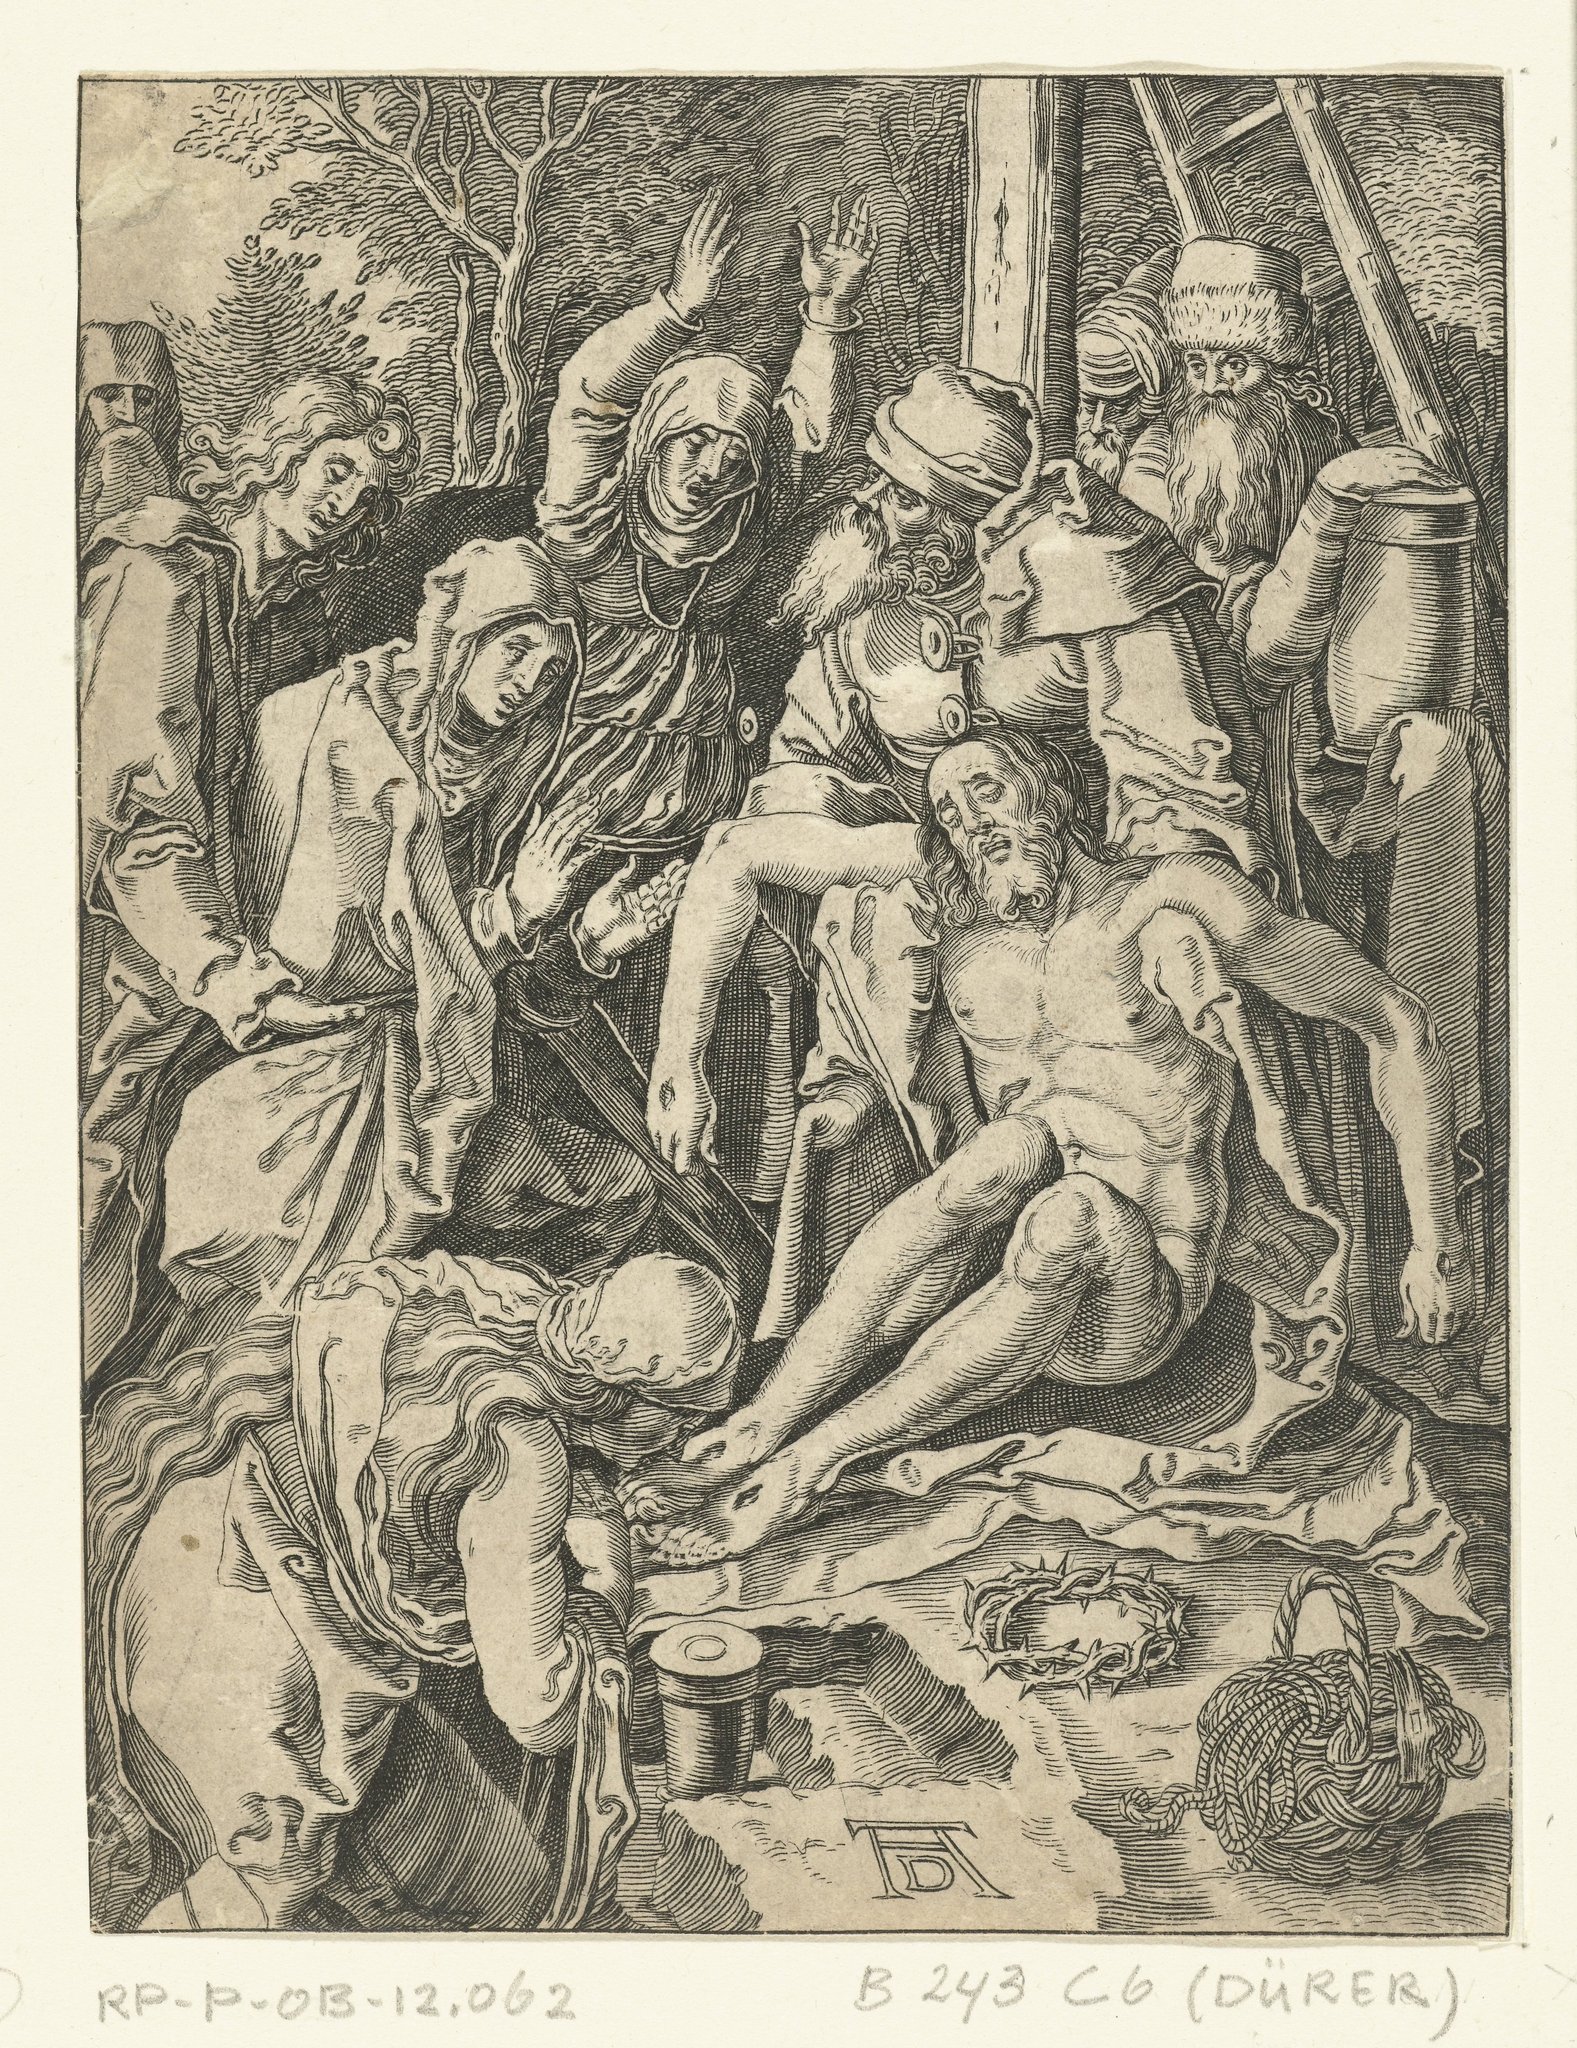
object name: print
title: Bewening van dode Christus door familie en vrienden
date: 1510-1699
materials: paper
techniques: engraving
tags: the mourning over the dead christ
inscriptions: collector's mark: Lugt 12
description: Prent naar houtsnede van Albrecht Dürer uit een serie van zevenendertig prenten met als onderwerp het levensverhaal van Christus, bekend als Passie van Christus. Illustratie gebruikt voor: Passio Christi ab Alberto Durer Nurenburgensi effigiata, Abraham van Waesberge (uitgever).